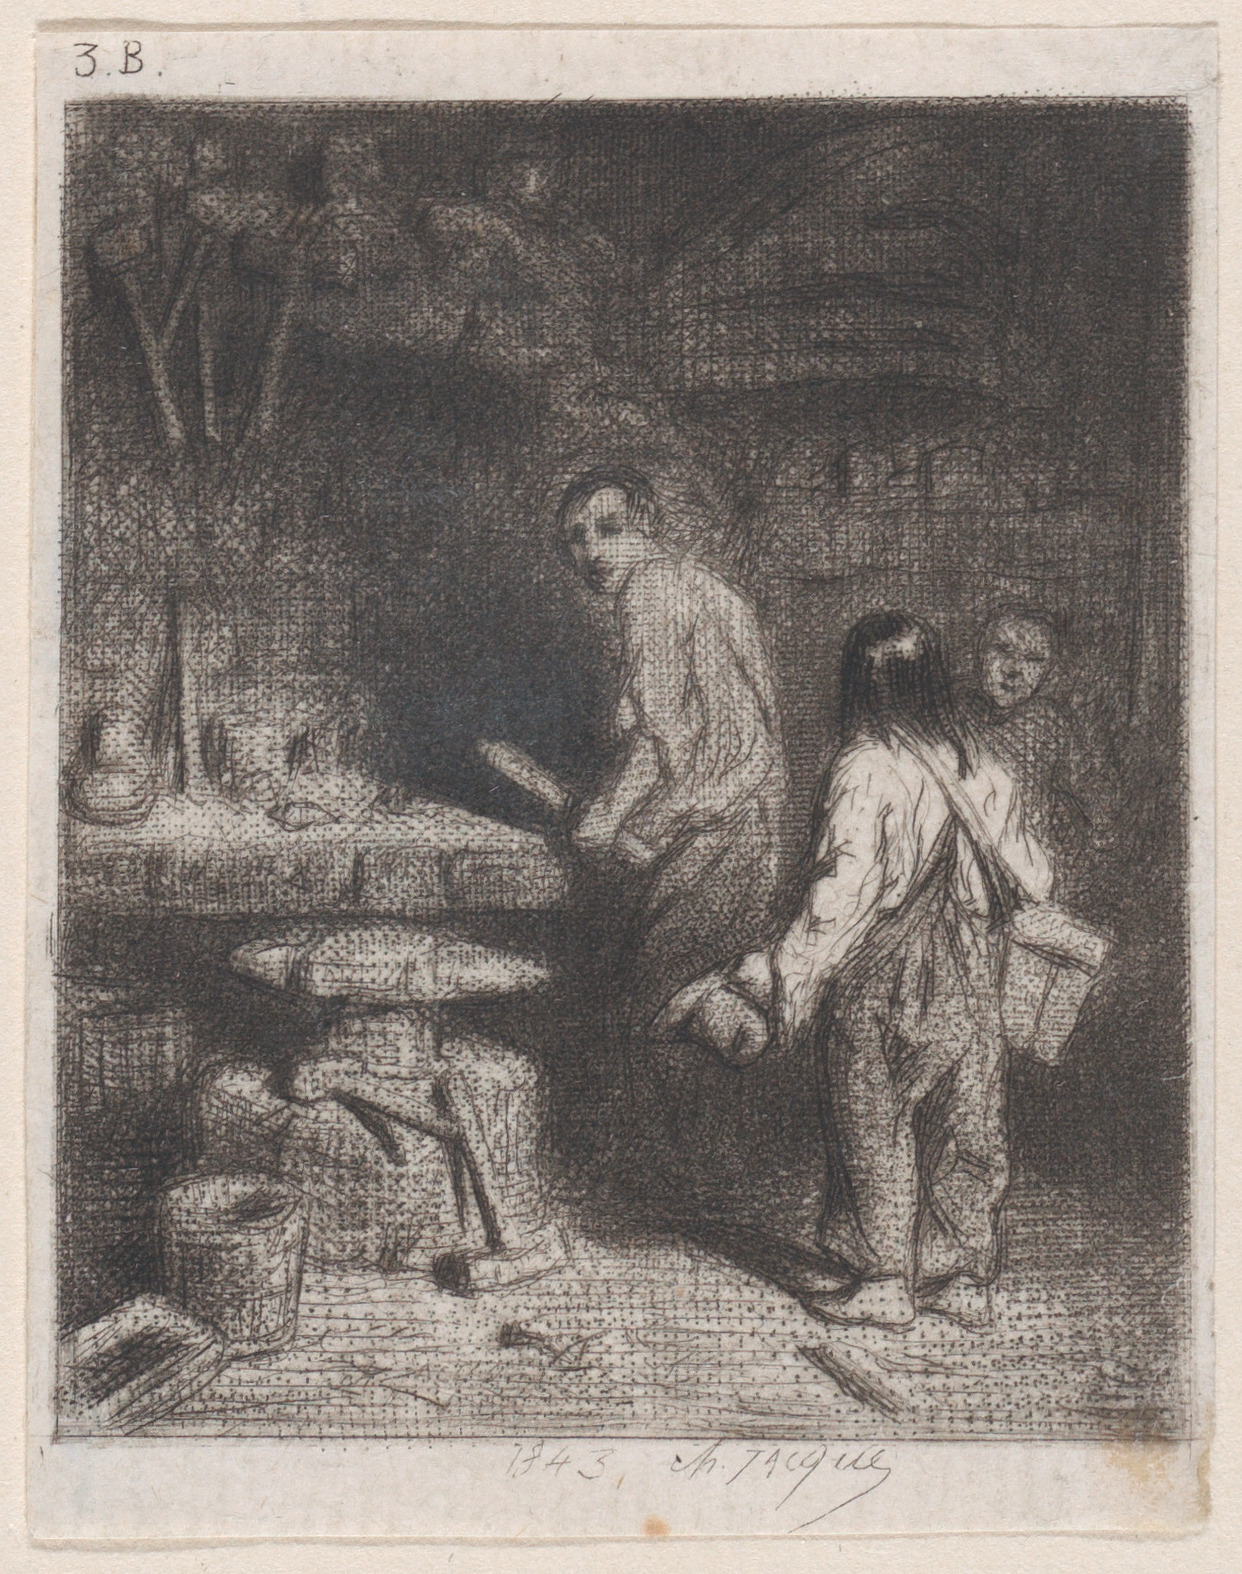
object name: print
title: The Little Blacksmith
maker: charles émile jacque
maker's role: artist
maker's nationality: french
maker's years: 1813-1894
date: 1843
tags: men,blacksmiths